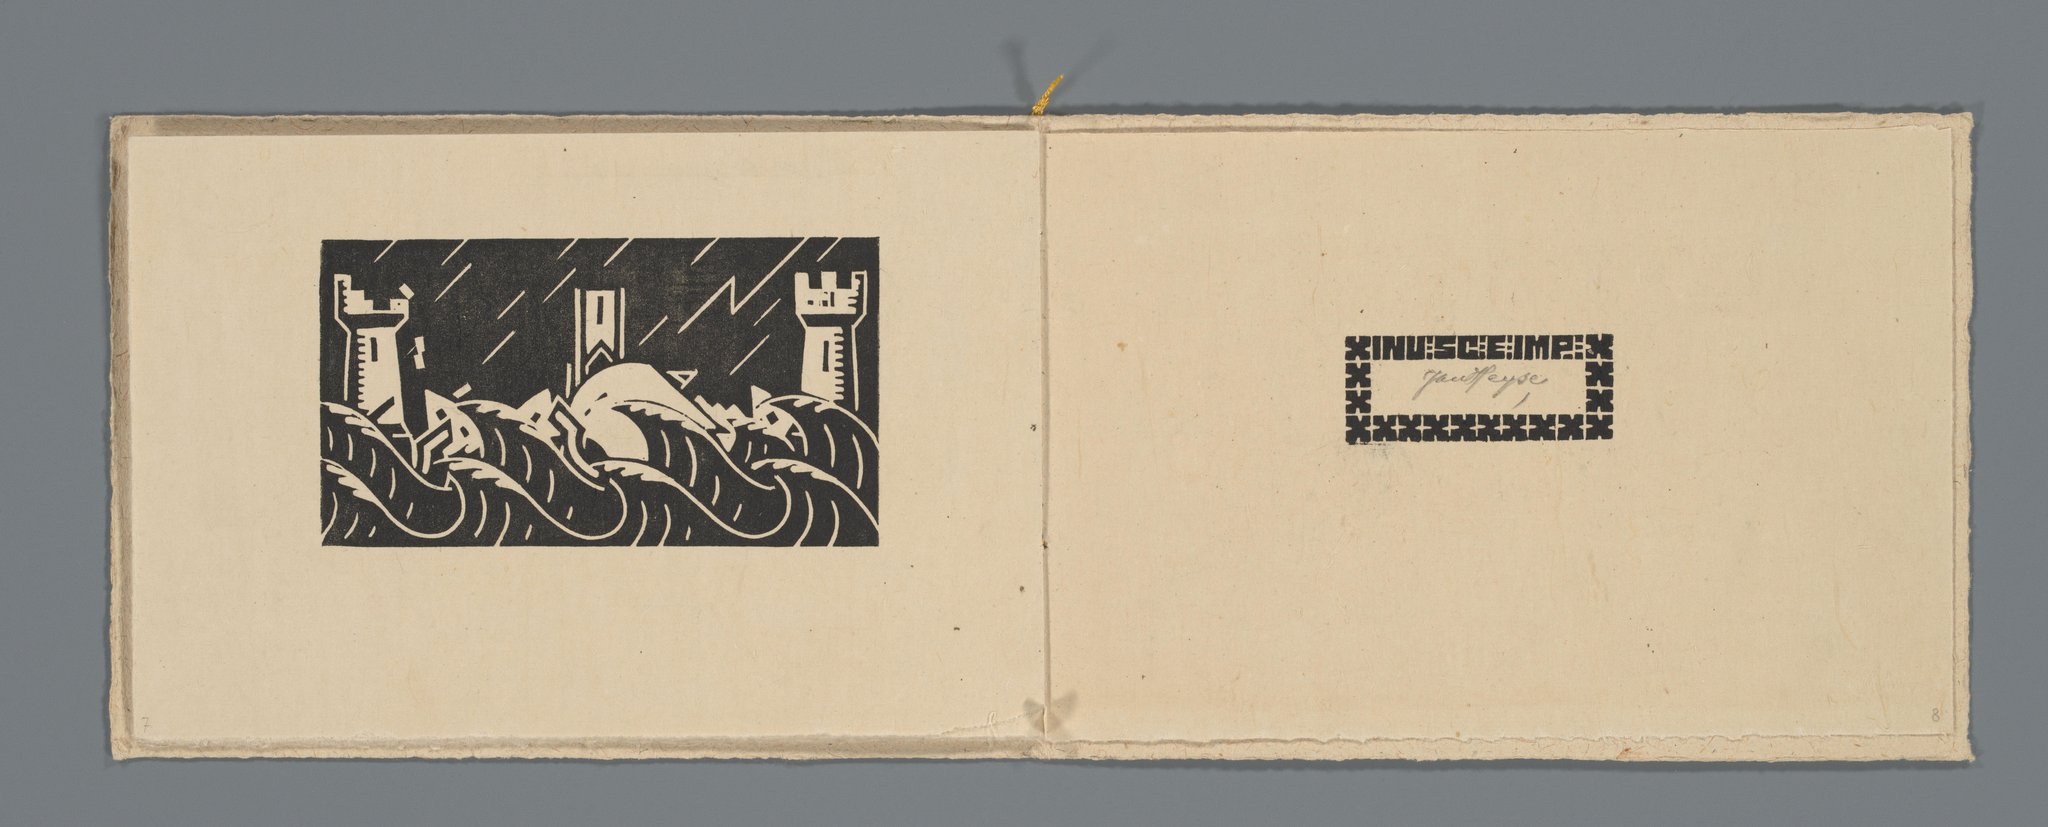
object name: print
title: Overstroming van Westenschouwen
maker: jan heyse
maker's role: painter, print maker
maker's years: 1882-1954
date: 1930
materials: paper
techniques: woodcut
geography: veere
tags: towers ~ fortified city, church (exterior), flood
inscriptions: date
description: De torens en kerk van Westenschouwen worden overstroomd. De linker toren brokkelt af. In het midden vergaat een schip. Onderdeel van album 'Westenschouwe'.